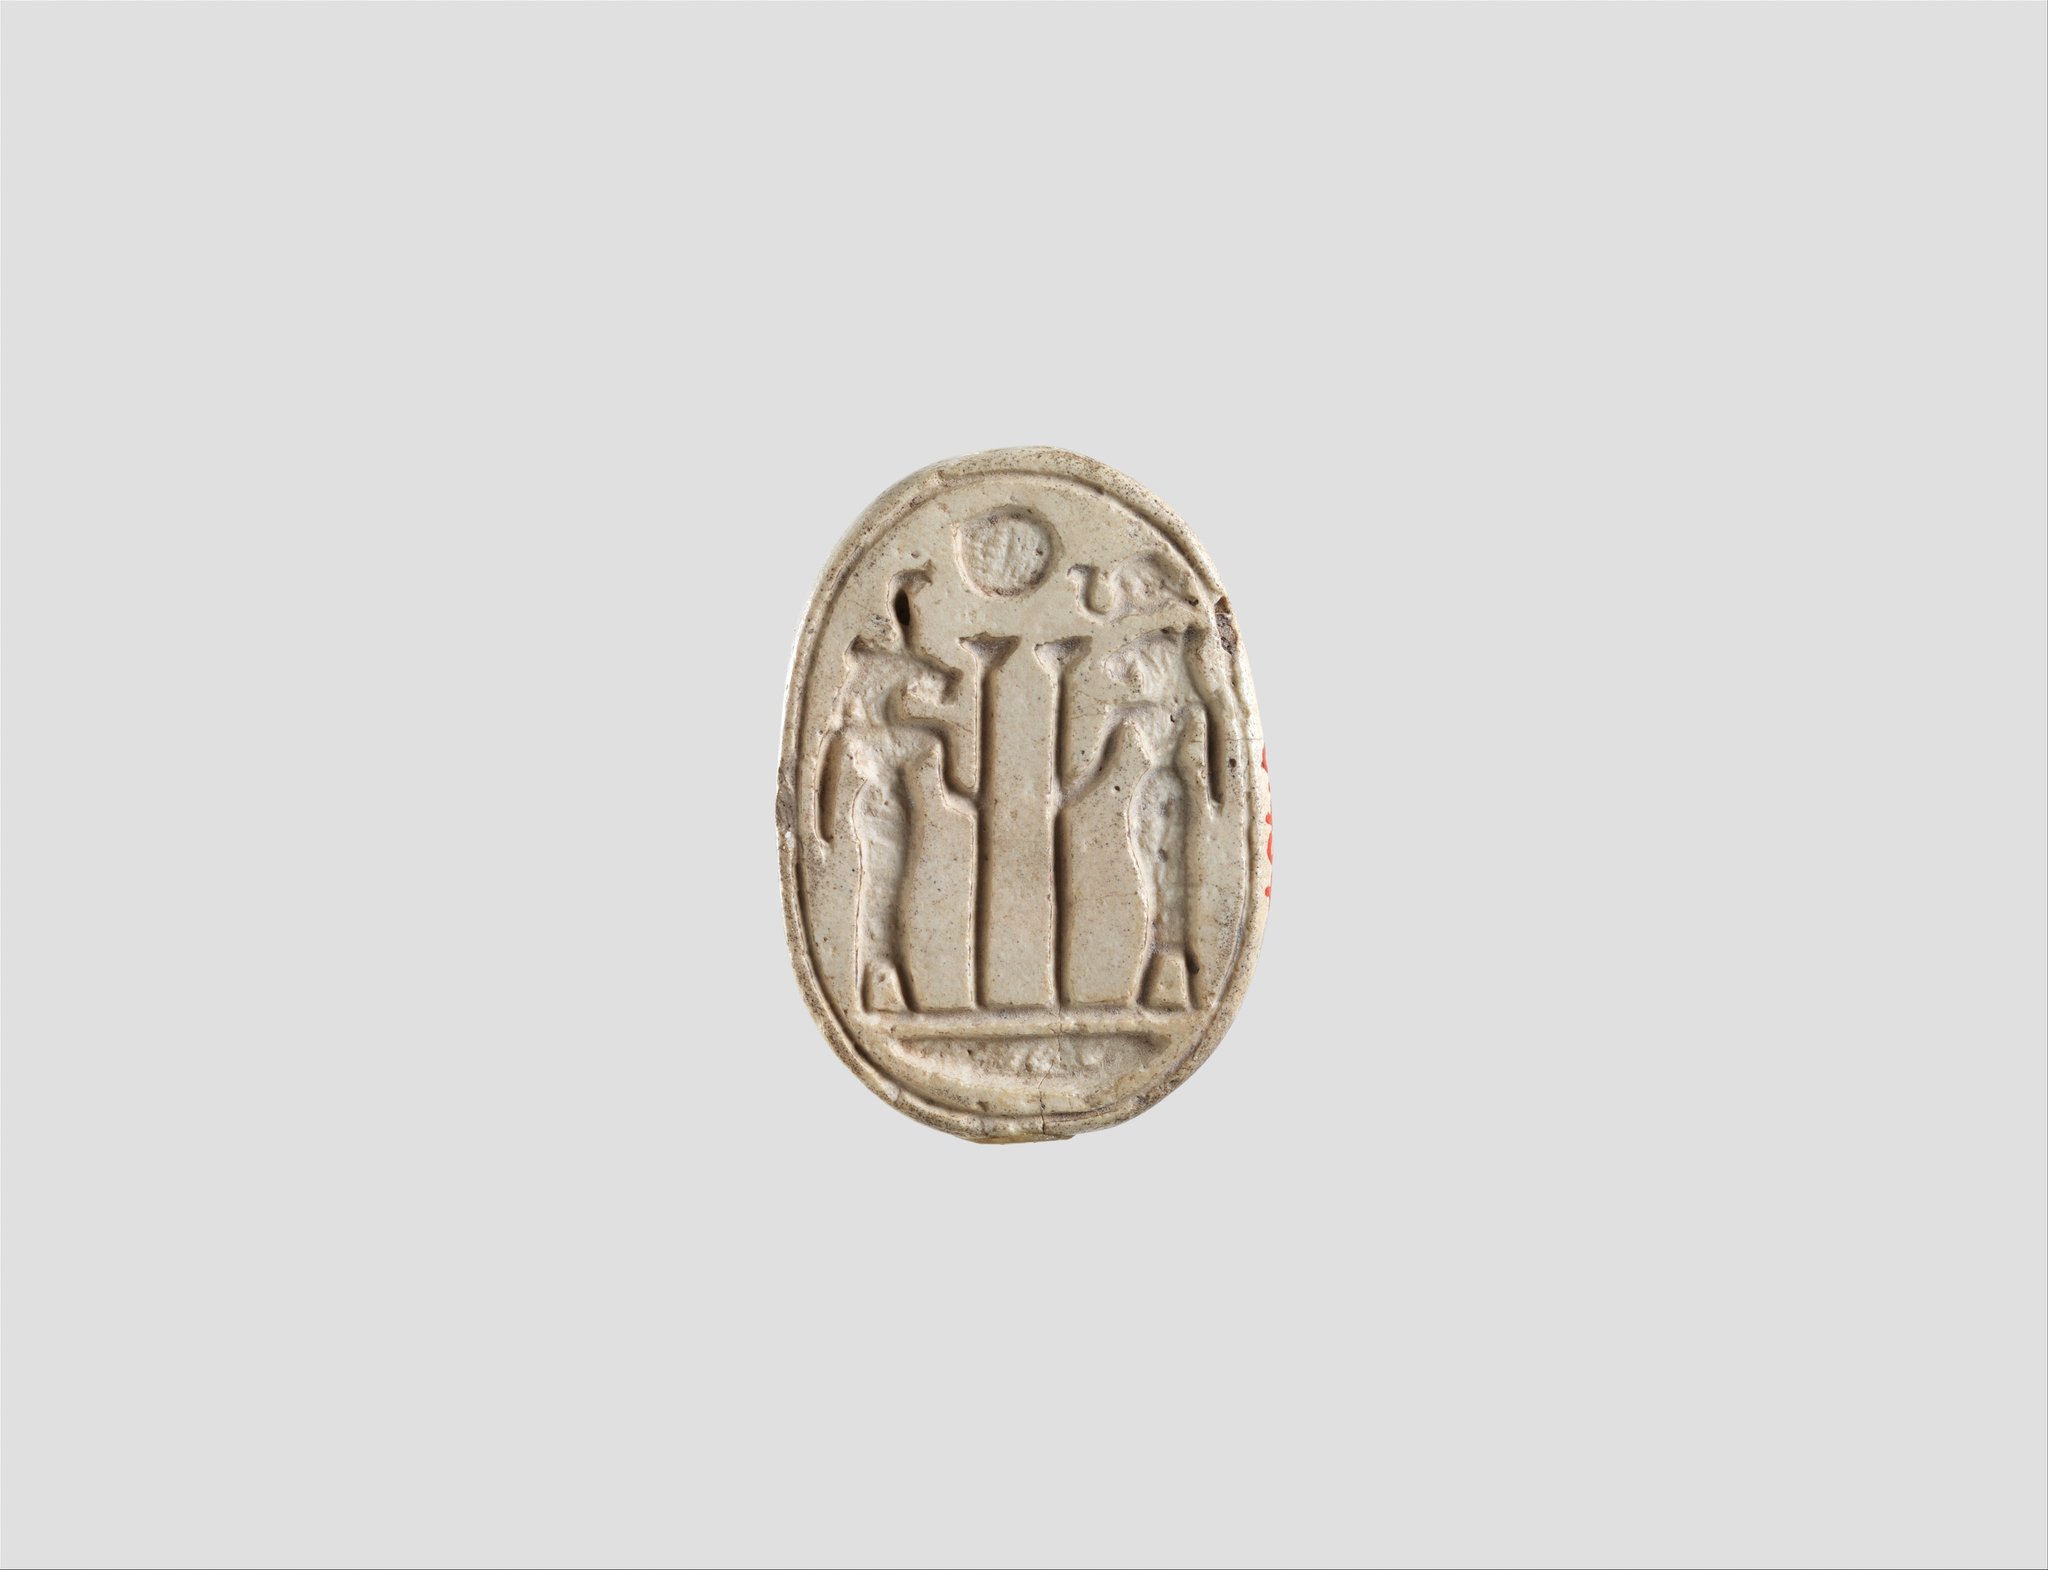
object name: scarab, lion headed sakhmet, cat headed bastet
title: Scarab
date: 1295-1070 BCE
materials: faience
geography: egypt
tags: hieroglyphs,scarabs,goddess